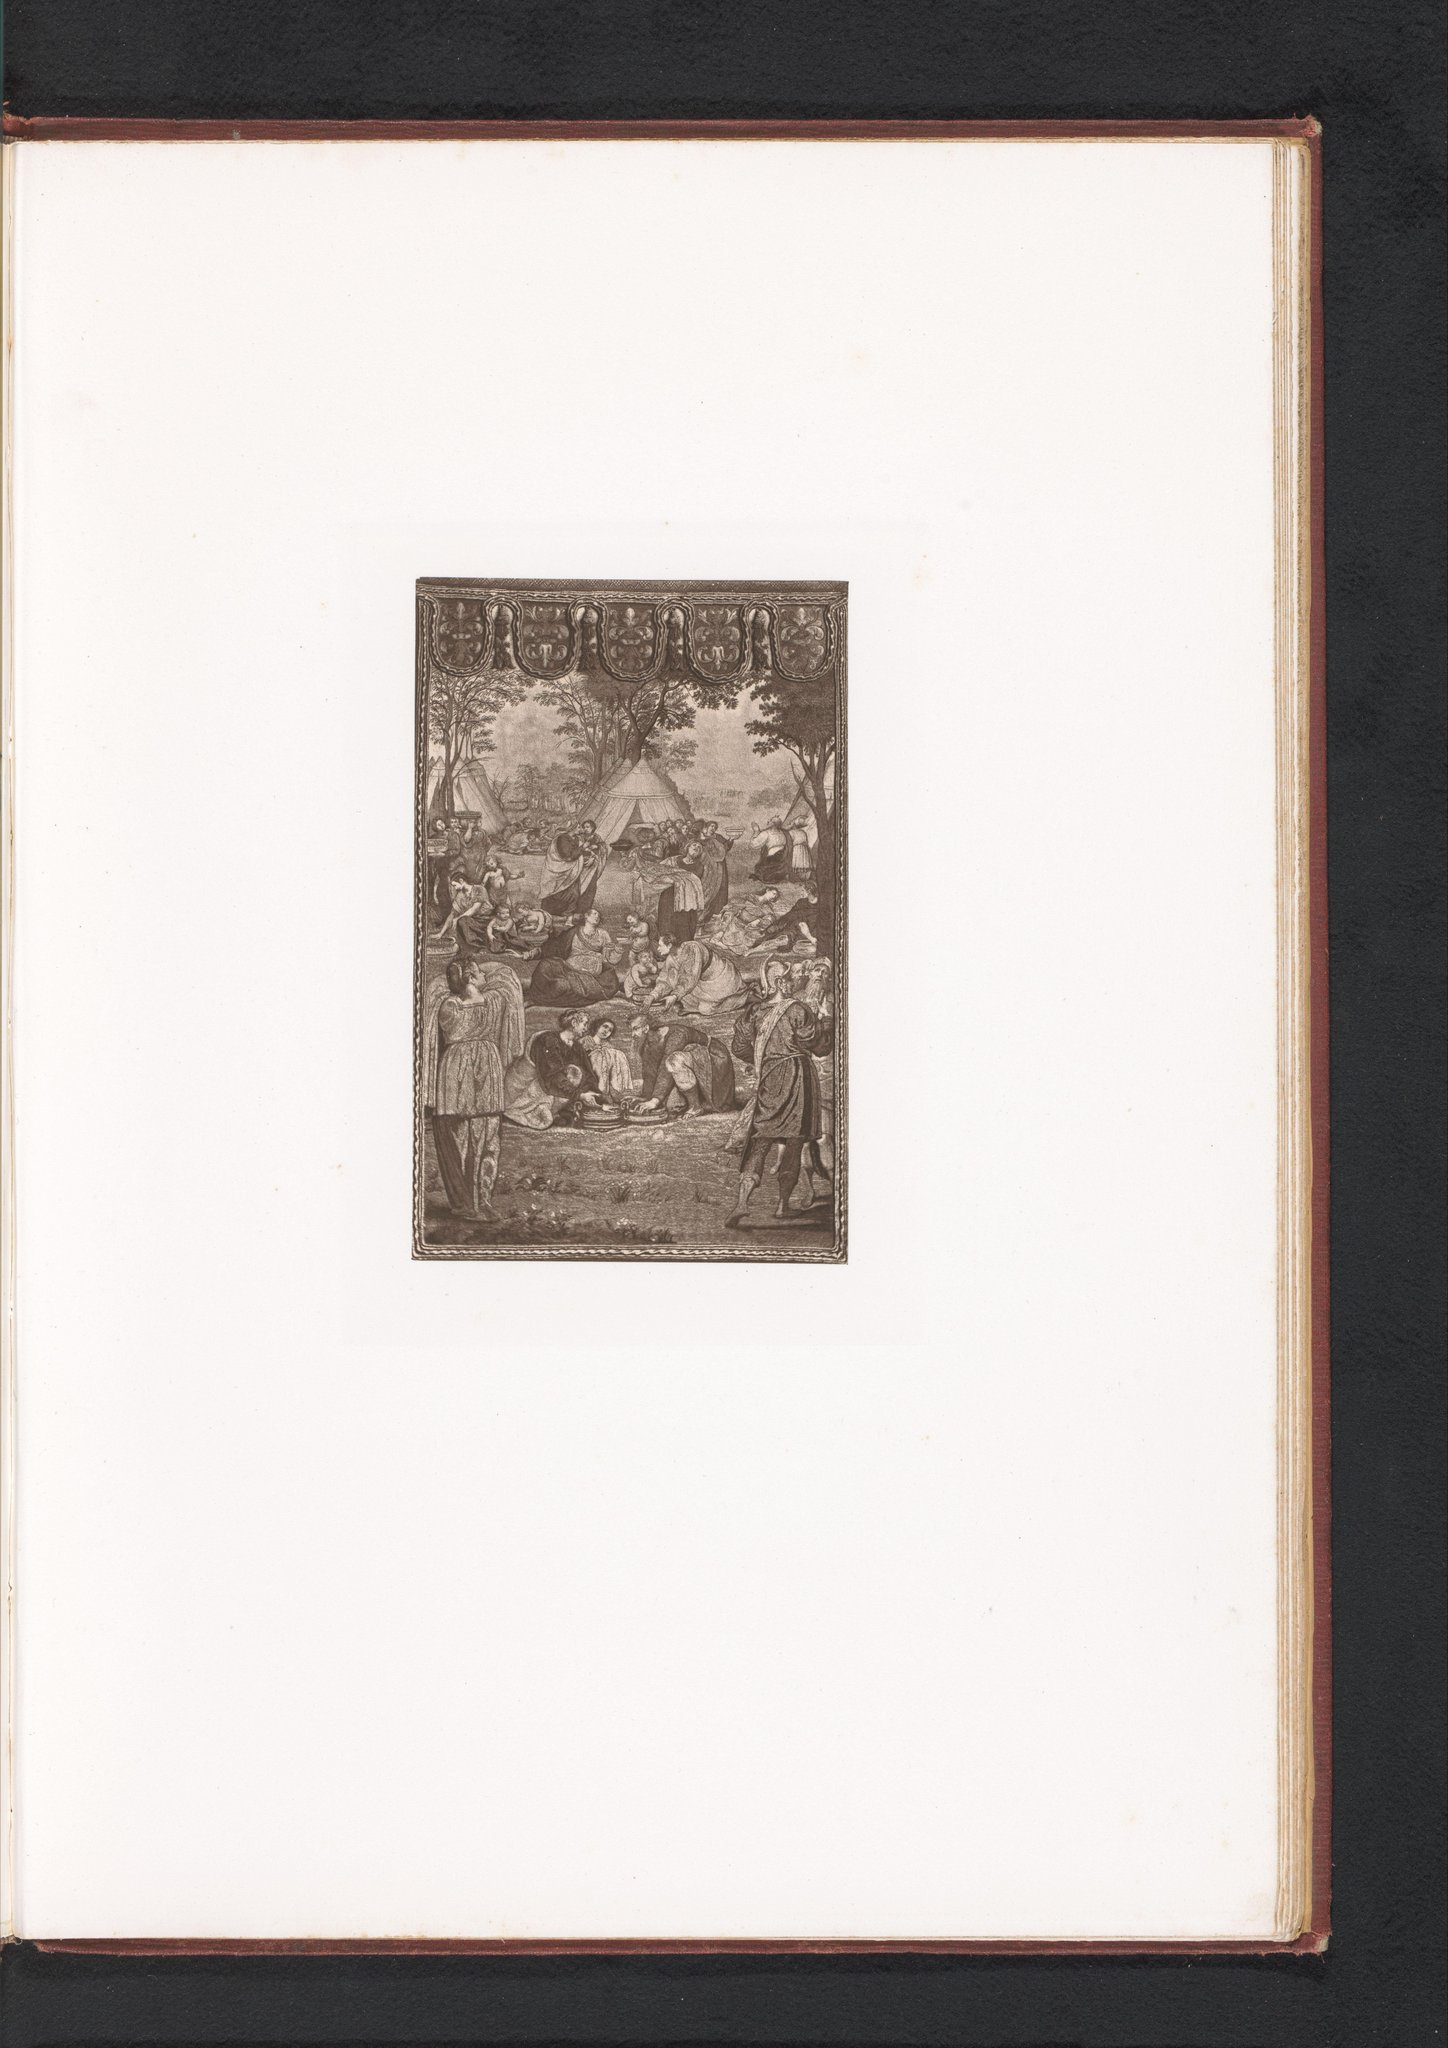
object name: photomechanical print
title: Borduurwerk met een Bijbelse voorstelling van het verzamelen van manna, opgesteld tijdens de Exposition Rétrospective van 1873 in Tours, Frankrijk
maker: gabriel blaise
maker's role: printer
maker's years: 1827-1897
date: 1873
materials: paper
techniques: woodburytype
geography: tours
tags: the gathering of manna (in baskets and pots), embroidery (ornamentation), temporary exhibition, 'salon'